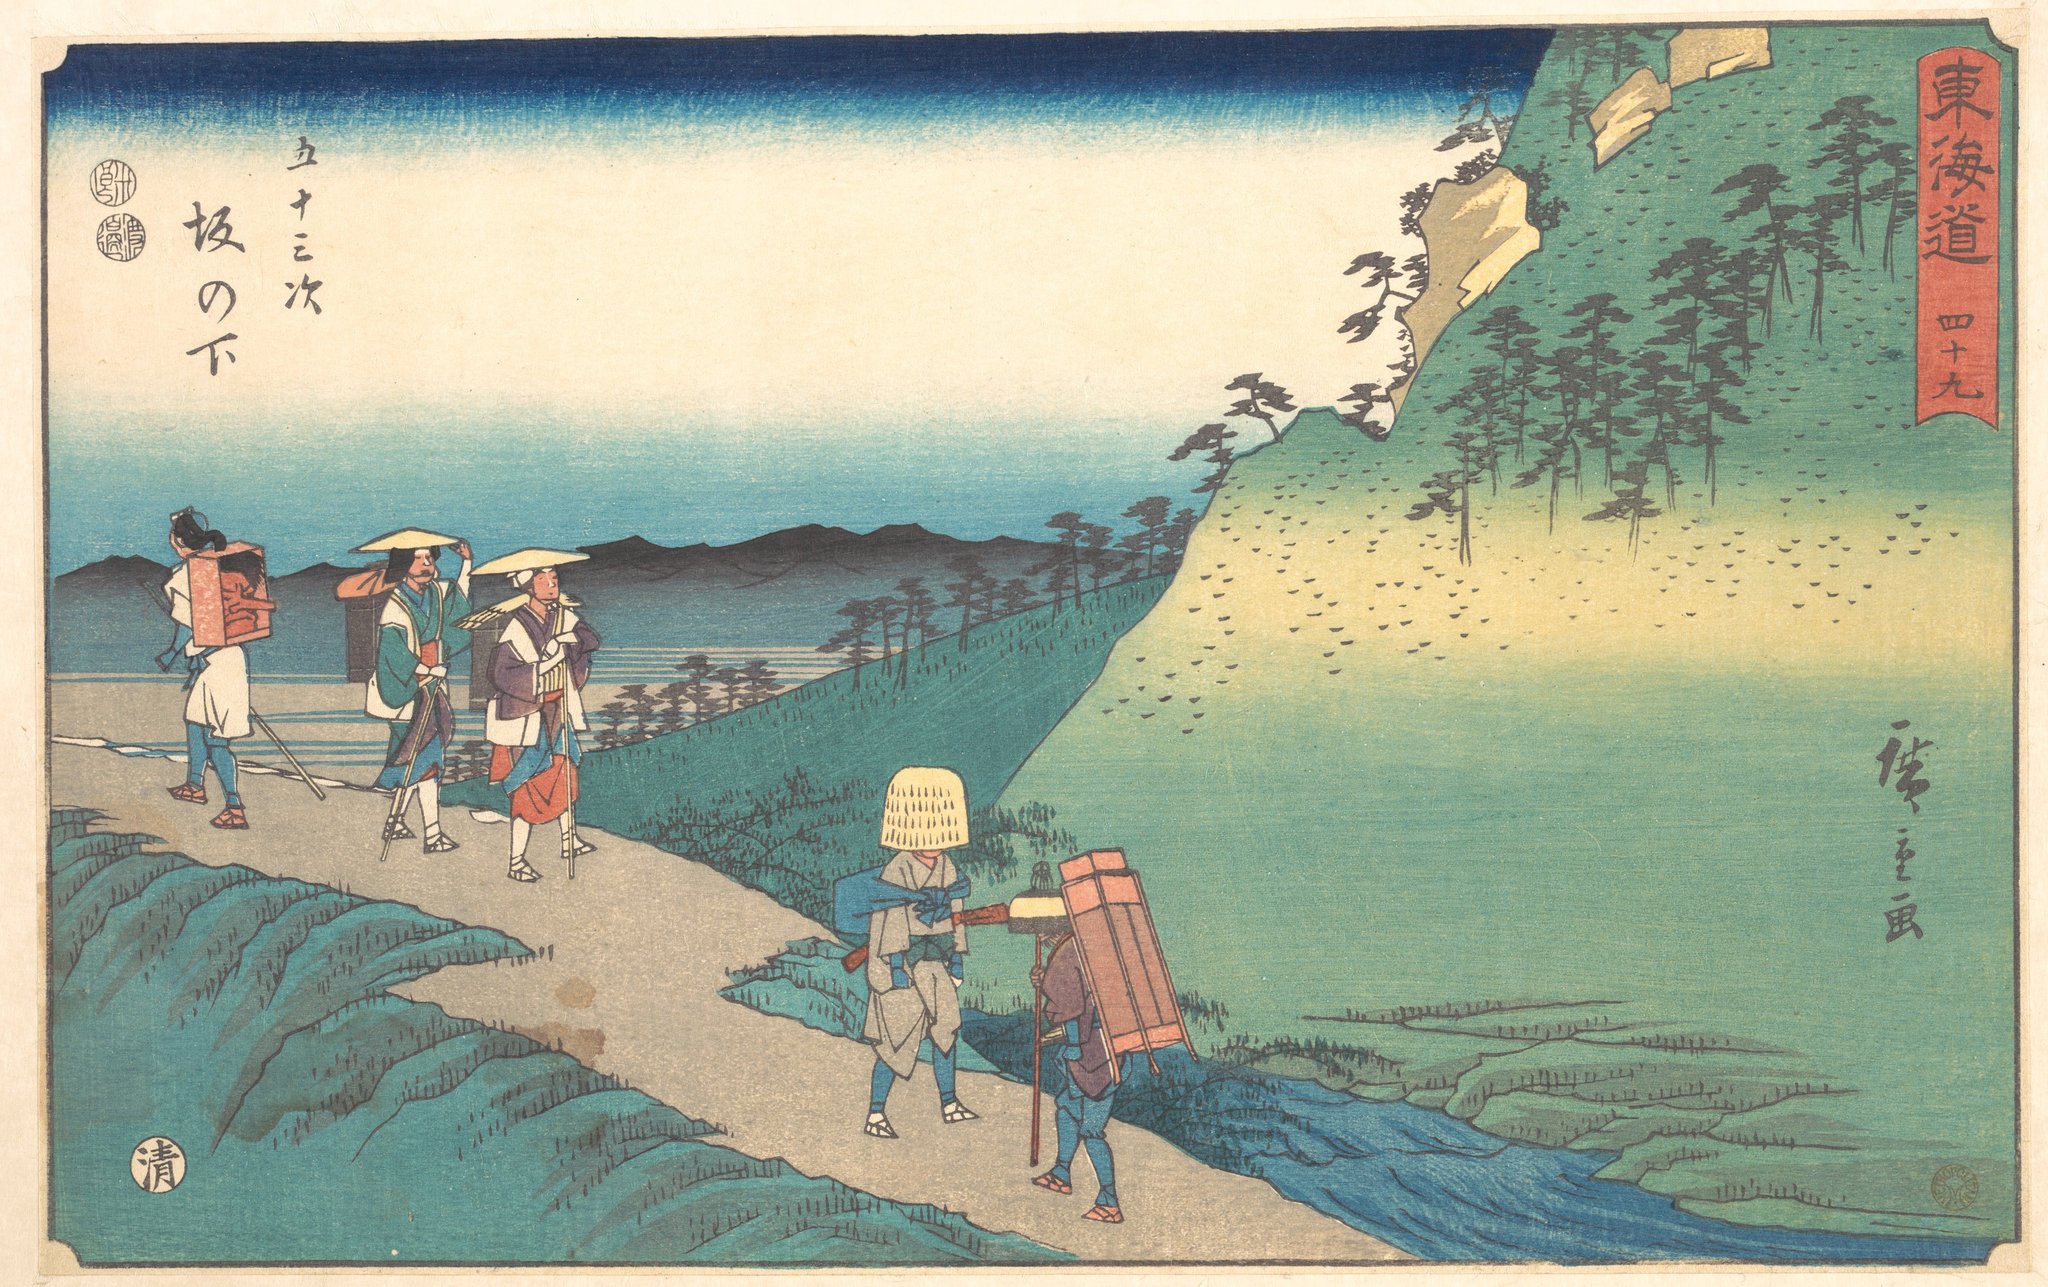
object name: print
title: Saka no Shita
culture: japanese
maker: utagawa hiroshige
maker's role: artist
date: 1840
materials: ink, paper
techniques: woodblock print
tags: human figures,mountains,landscapes,trees